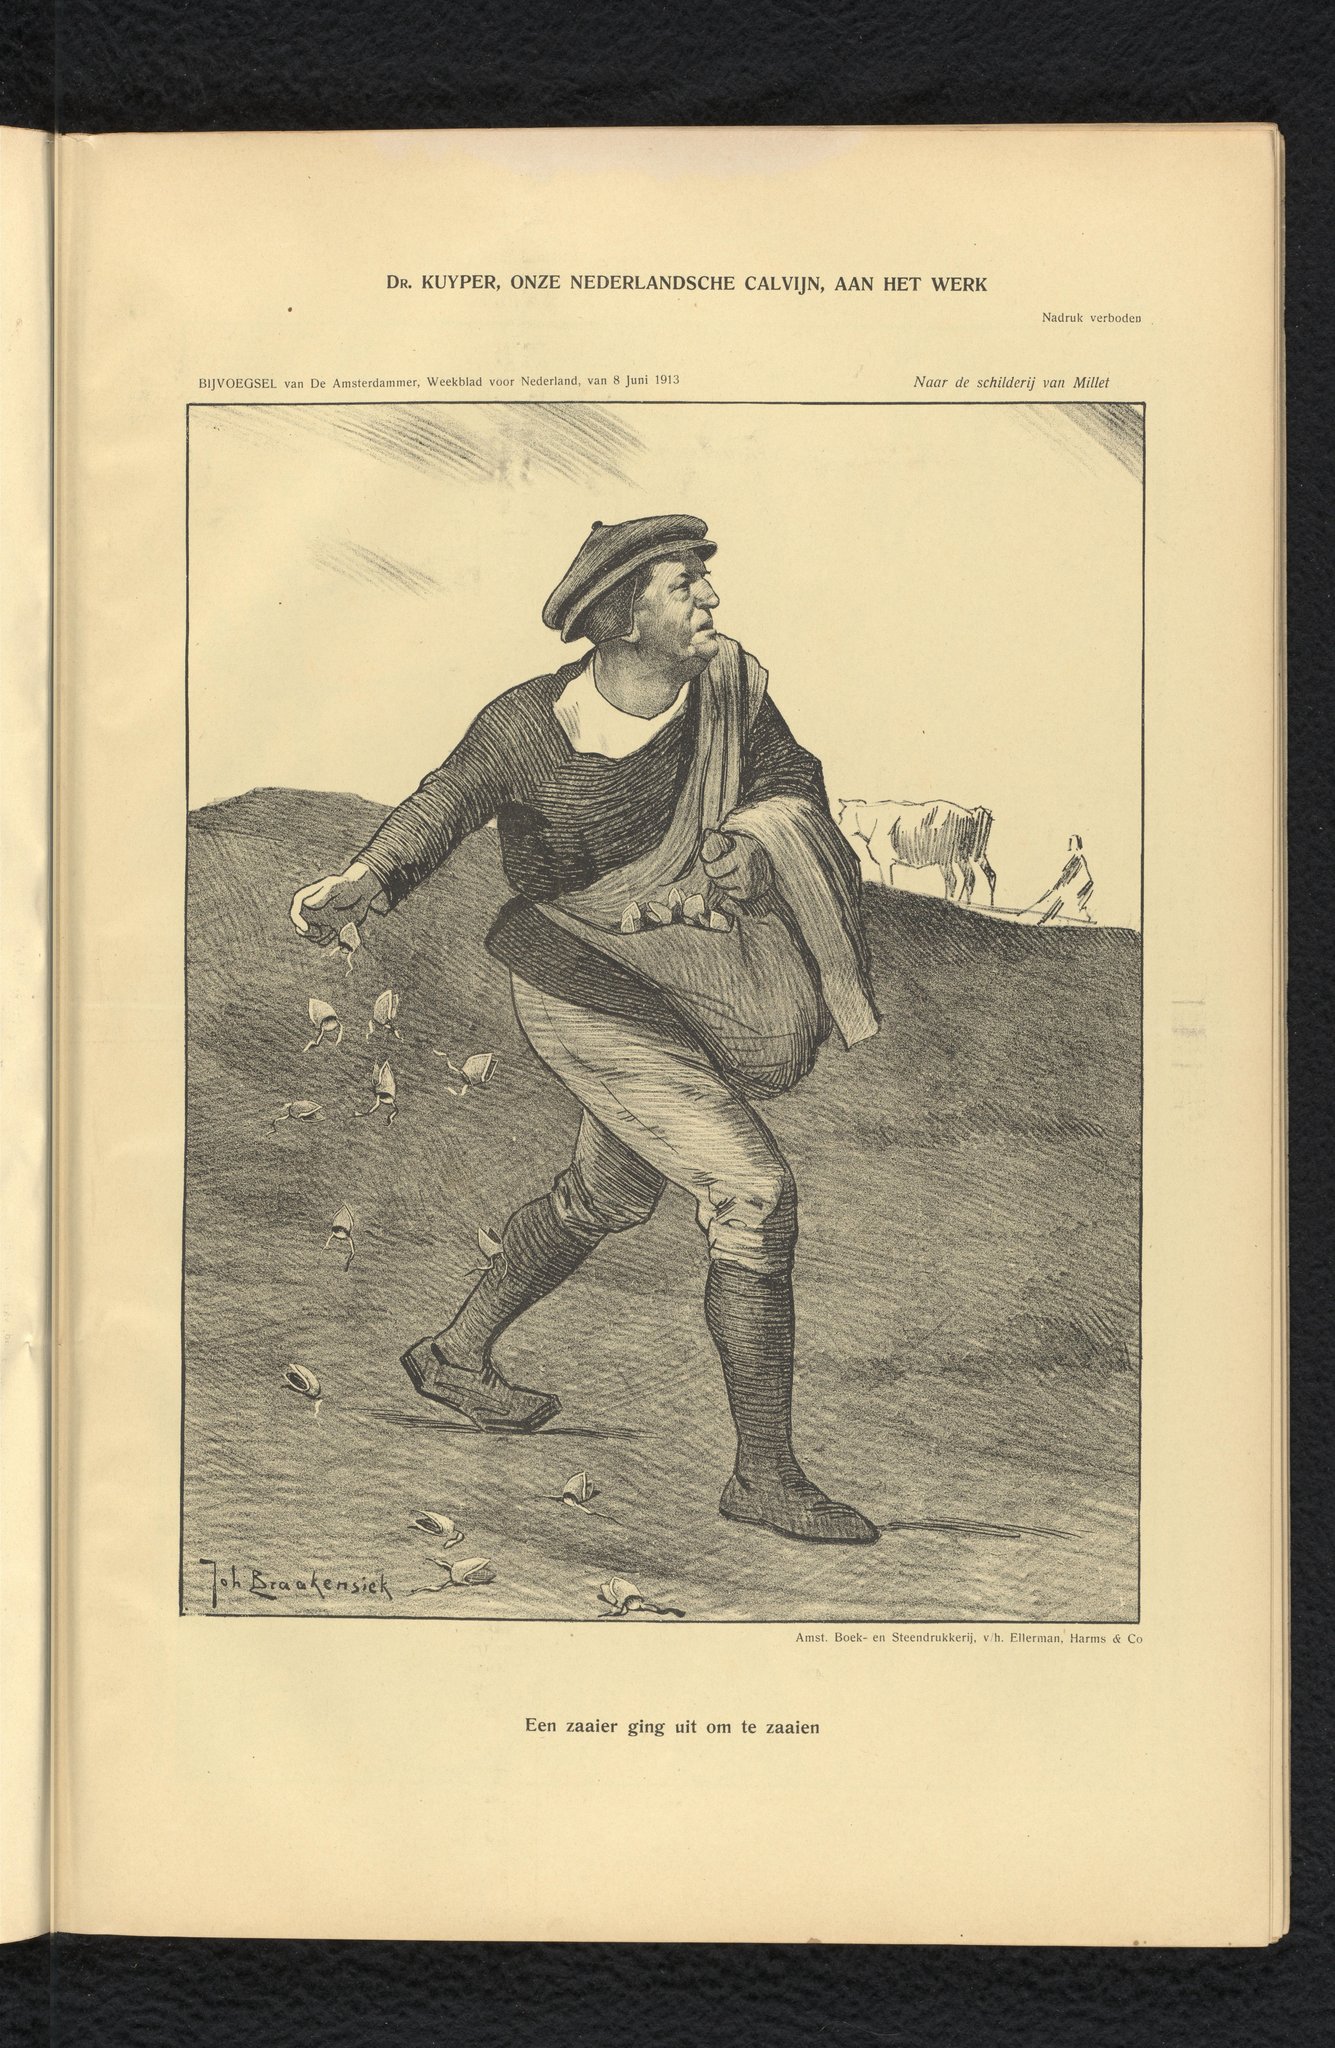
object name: cartoon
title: Dr. Kuyper, onze Nederlandsche Calvijn, aan het werk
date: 1913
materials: paper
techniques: lithograph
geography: netherlands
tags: the hague, abraham kuyper, sowing, political caricatures and satires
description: Abraham Kuyper als de zaaier die bisschopsmijters over het land zaait. Pastiche op het schilderij 'De Zaaier' van Jean-François Millet.